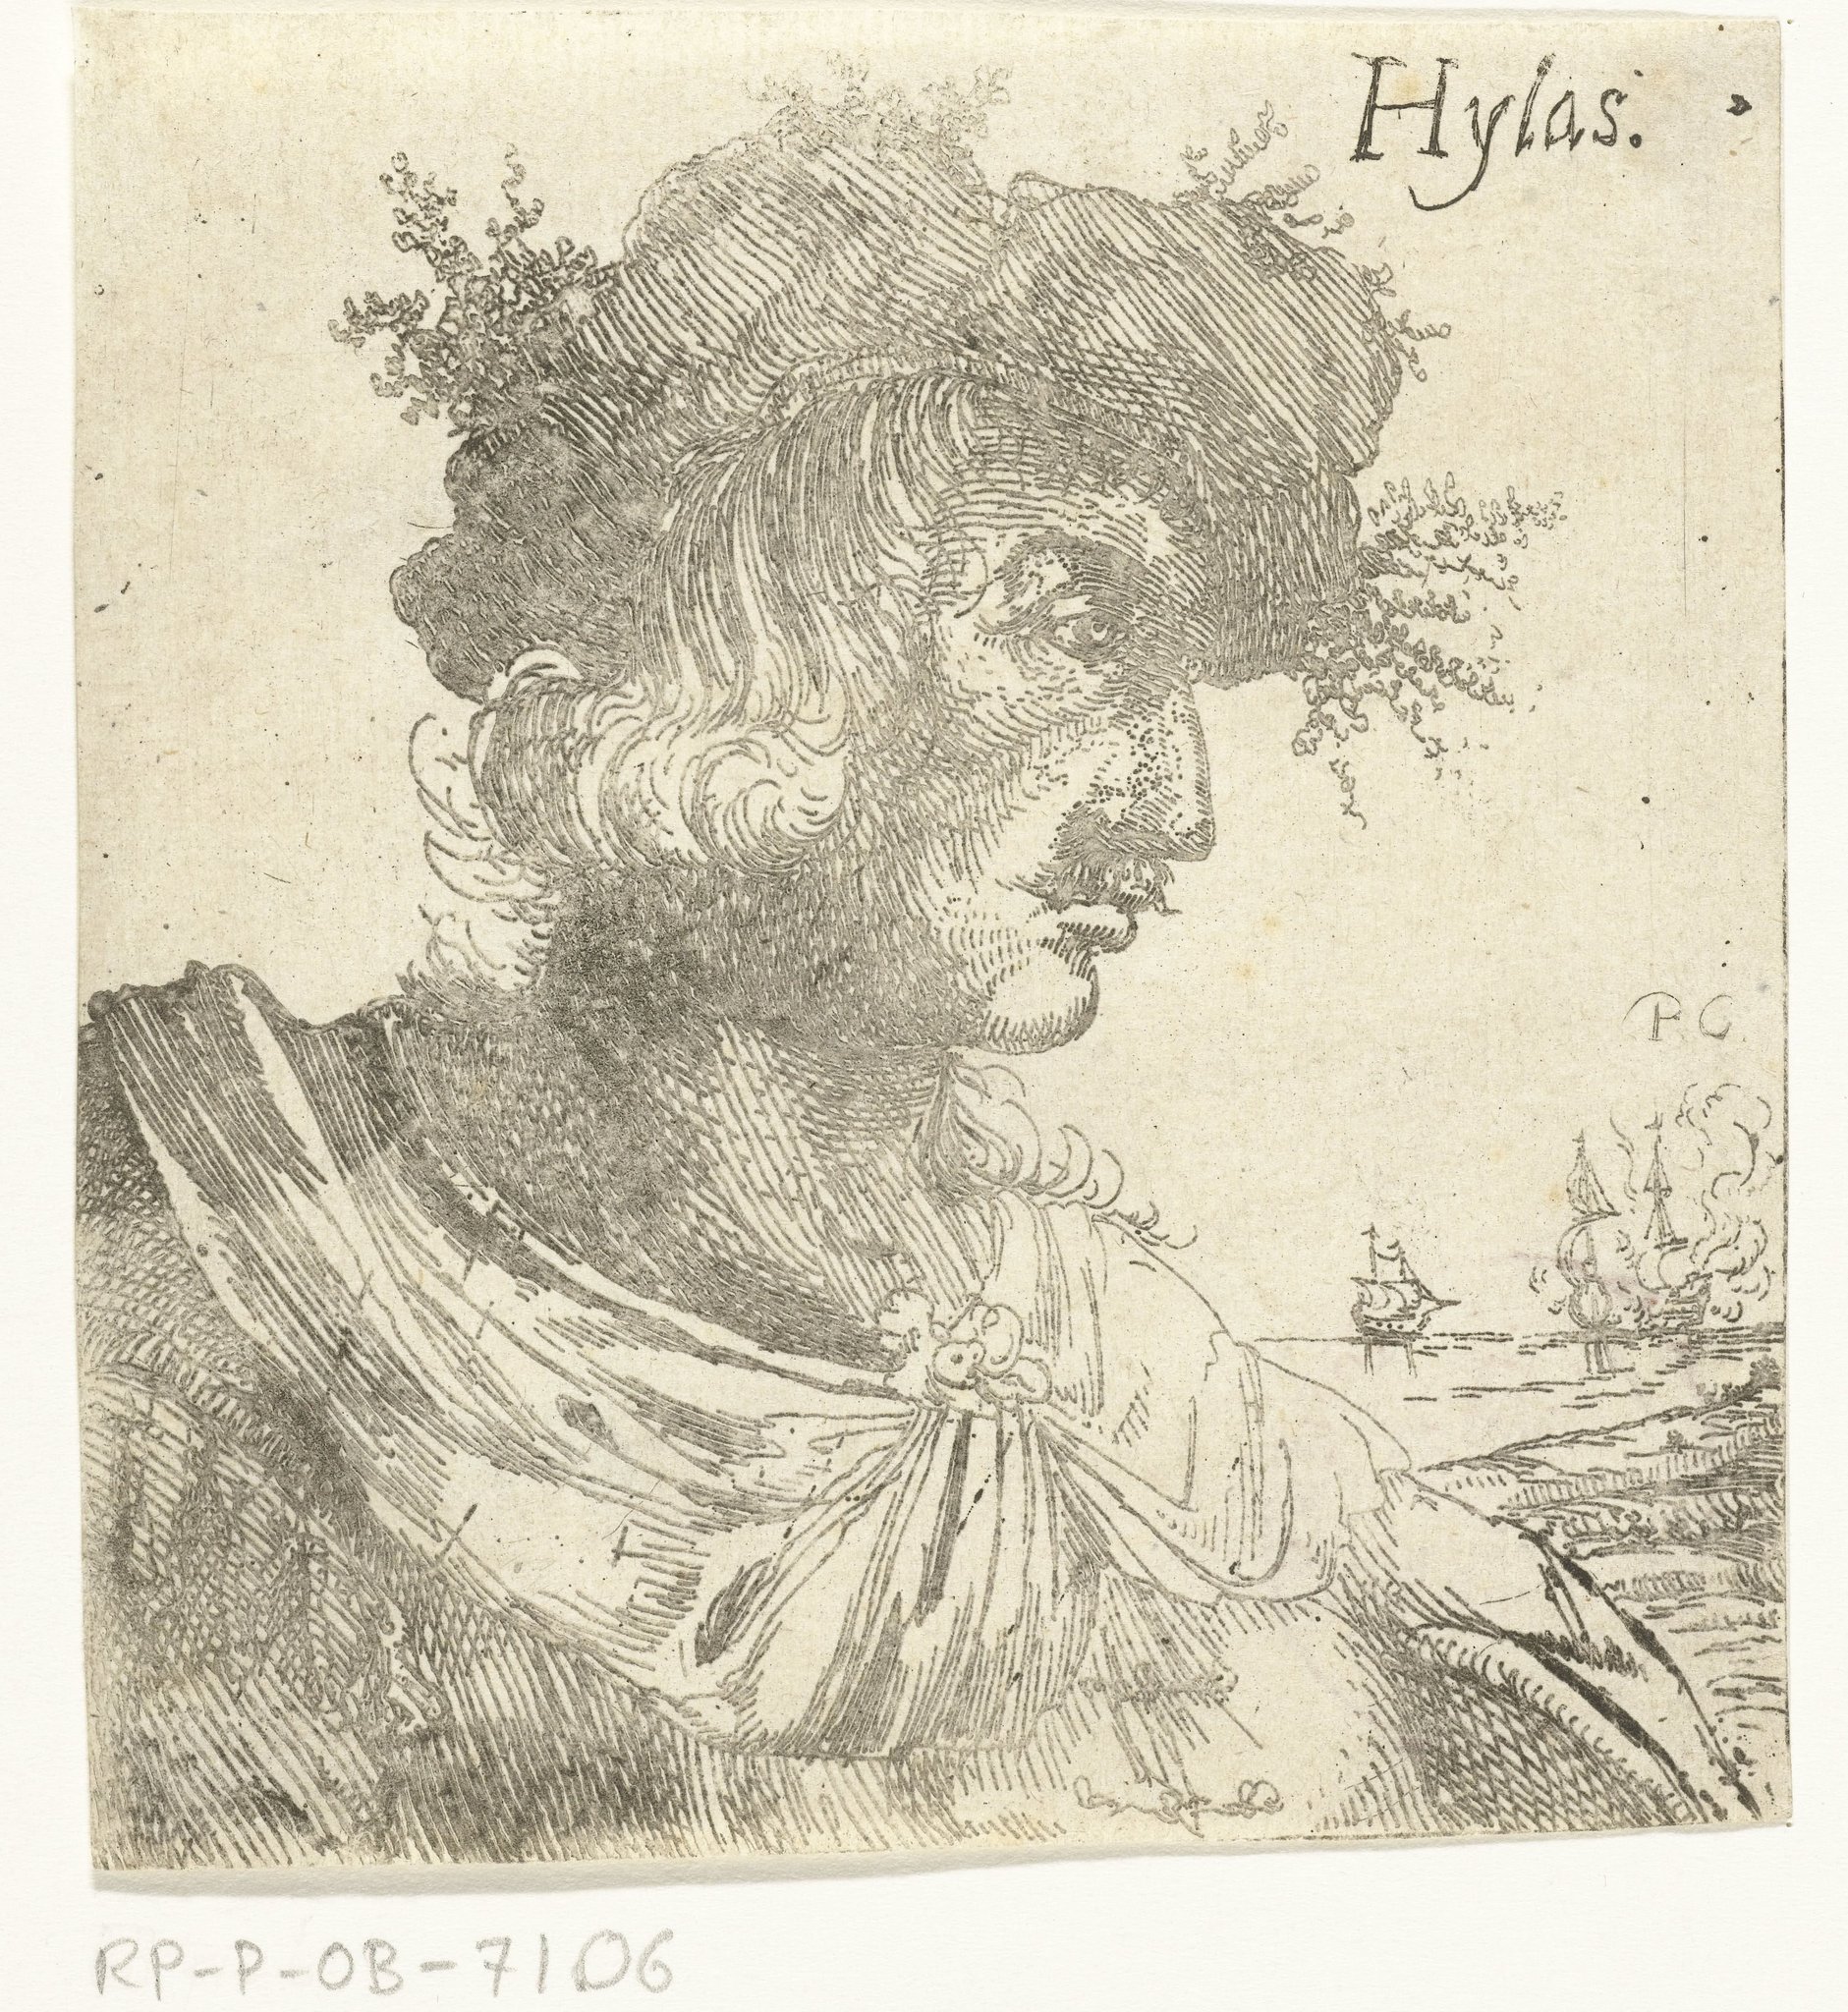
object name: print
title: Hylas de argonaut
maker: pieter casteleyn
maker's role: draughtsman, print maker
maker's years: 1618-1676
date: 1633-1676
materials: paper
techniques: etching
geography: haarlem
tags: the argonauts in mysia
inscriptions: collector's mark: Lugt 240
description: Een jonge man met snor en krullend haar en profiel naar rechts. Op de achtergrond een zeeslag.